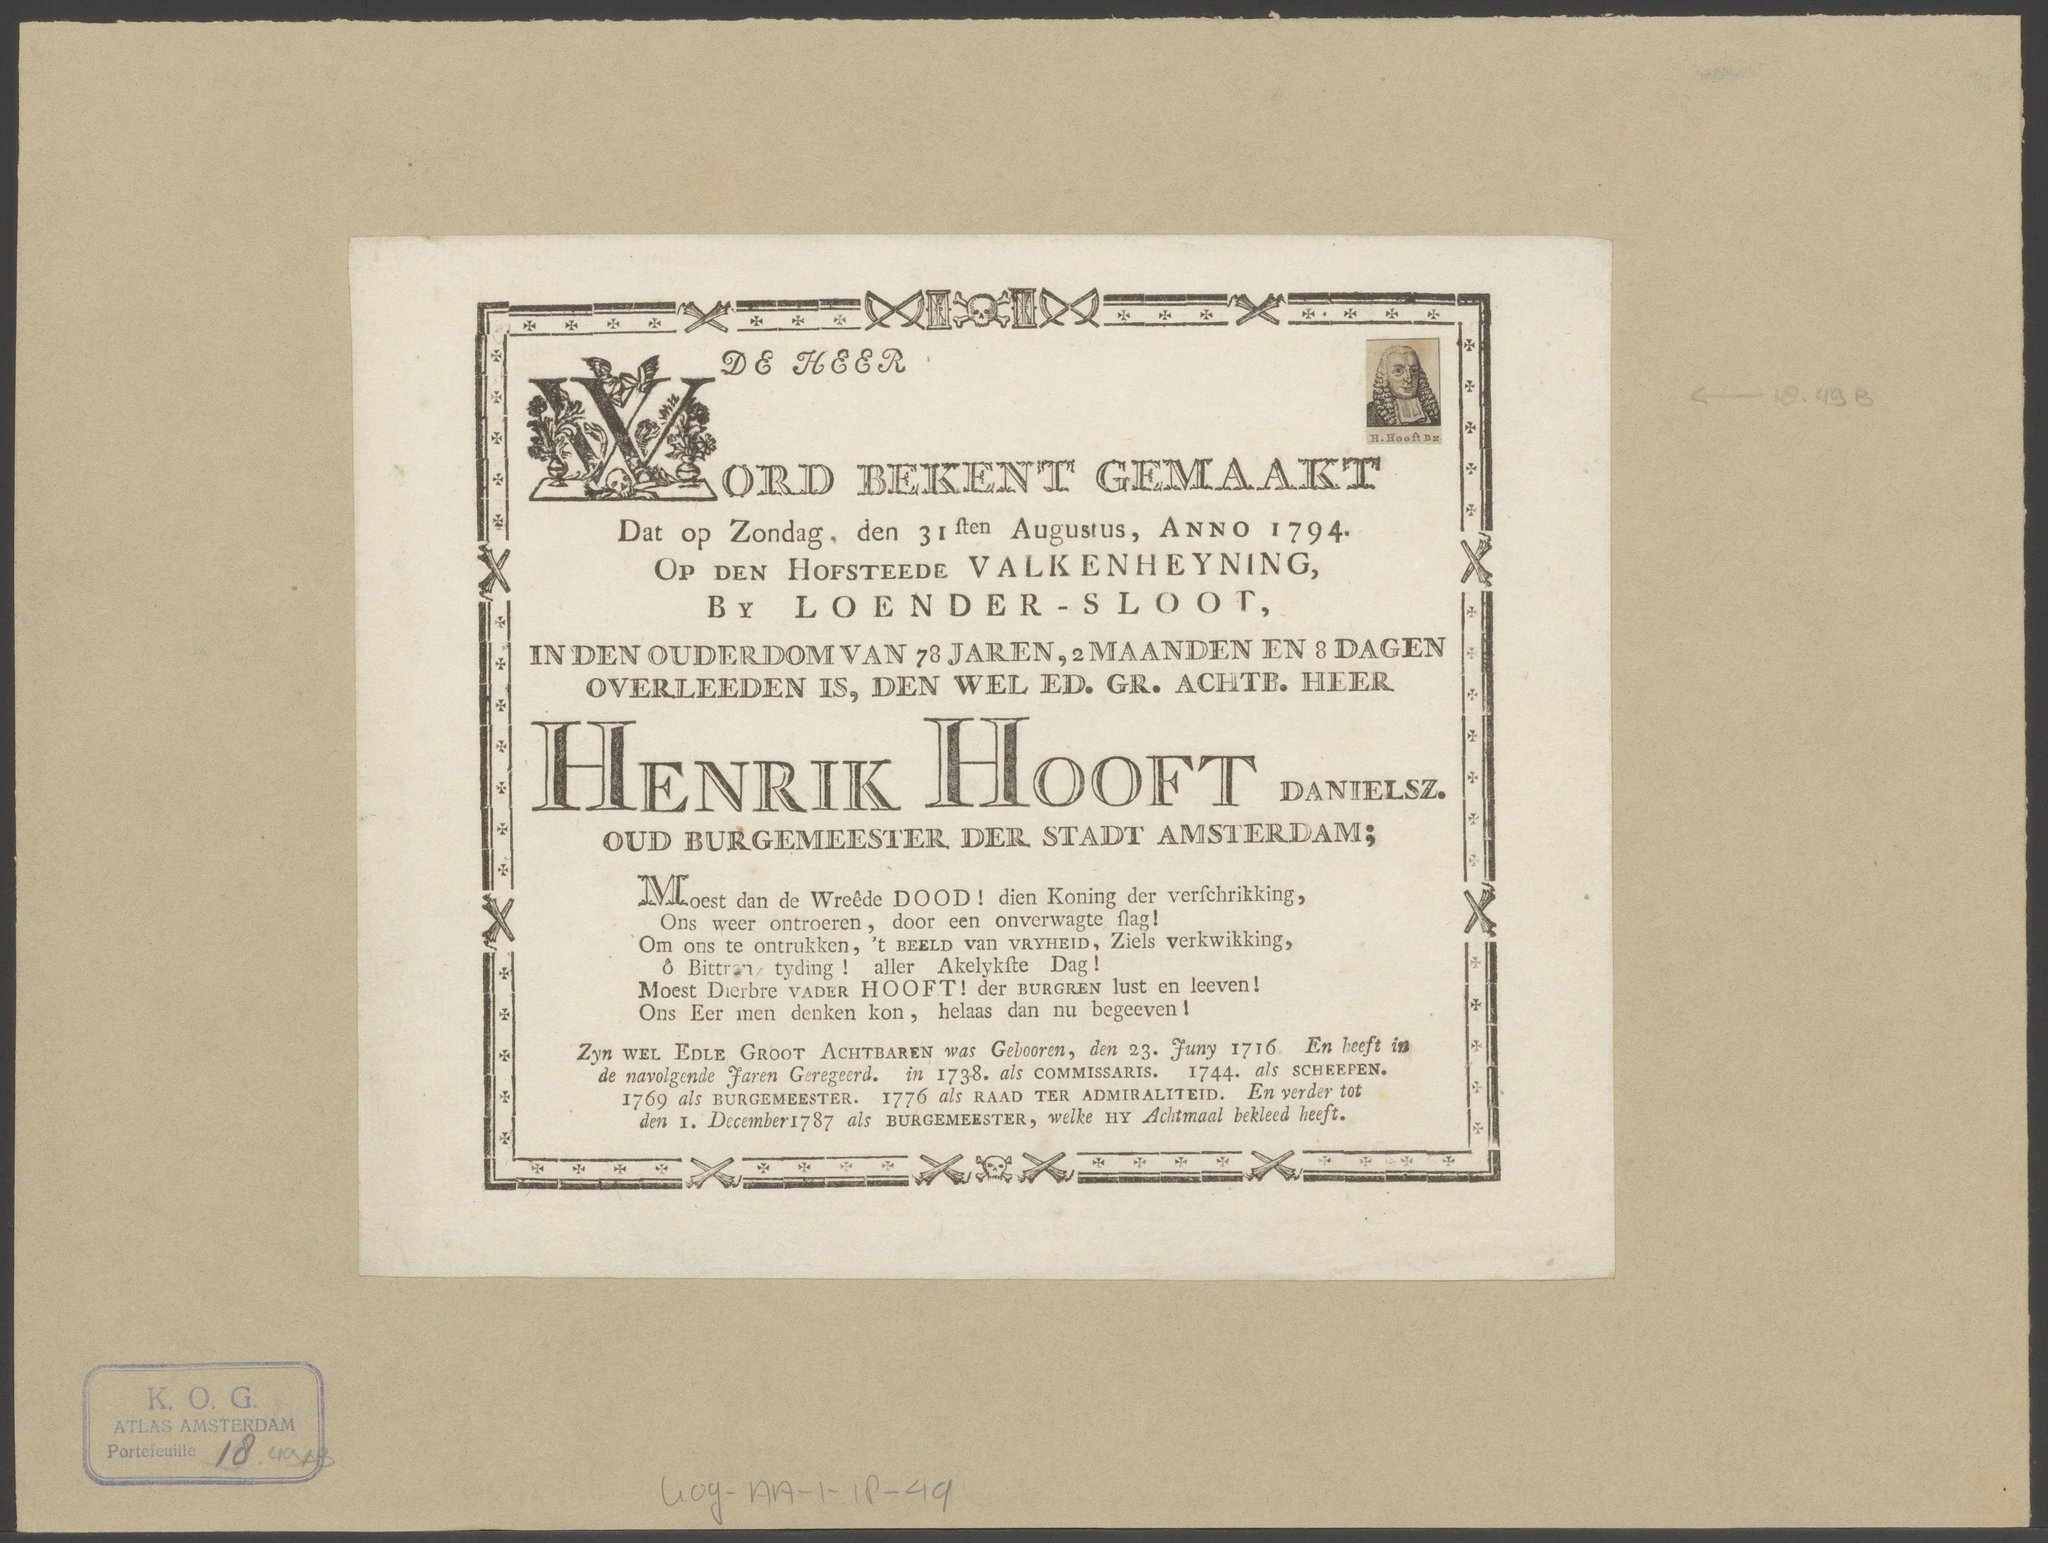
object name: print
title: Aankondiging van het overlijden van Hendrik Danielsz. Hooft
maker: Anonymous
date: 1794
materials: paper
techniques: etching, letterpress printing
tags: amsterdam, mayor, hendrik danielsz. hooft, announcement of death, mayor, burgomaster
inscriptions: collector's mark: ‘18.49AB’ Lugt 1641b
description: Onderwerpsrubriek binnen de Atlas Amsterdam: Herinneringen aan regeringsleden en hunne huisgezinnen [voor 1800].